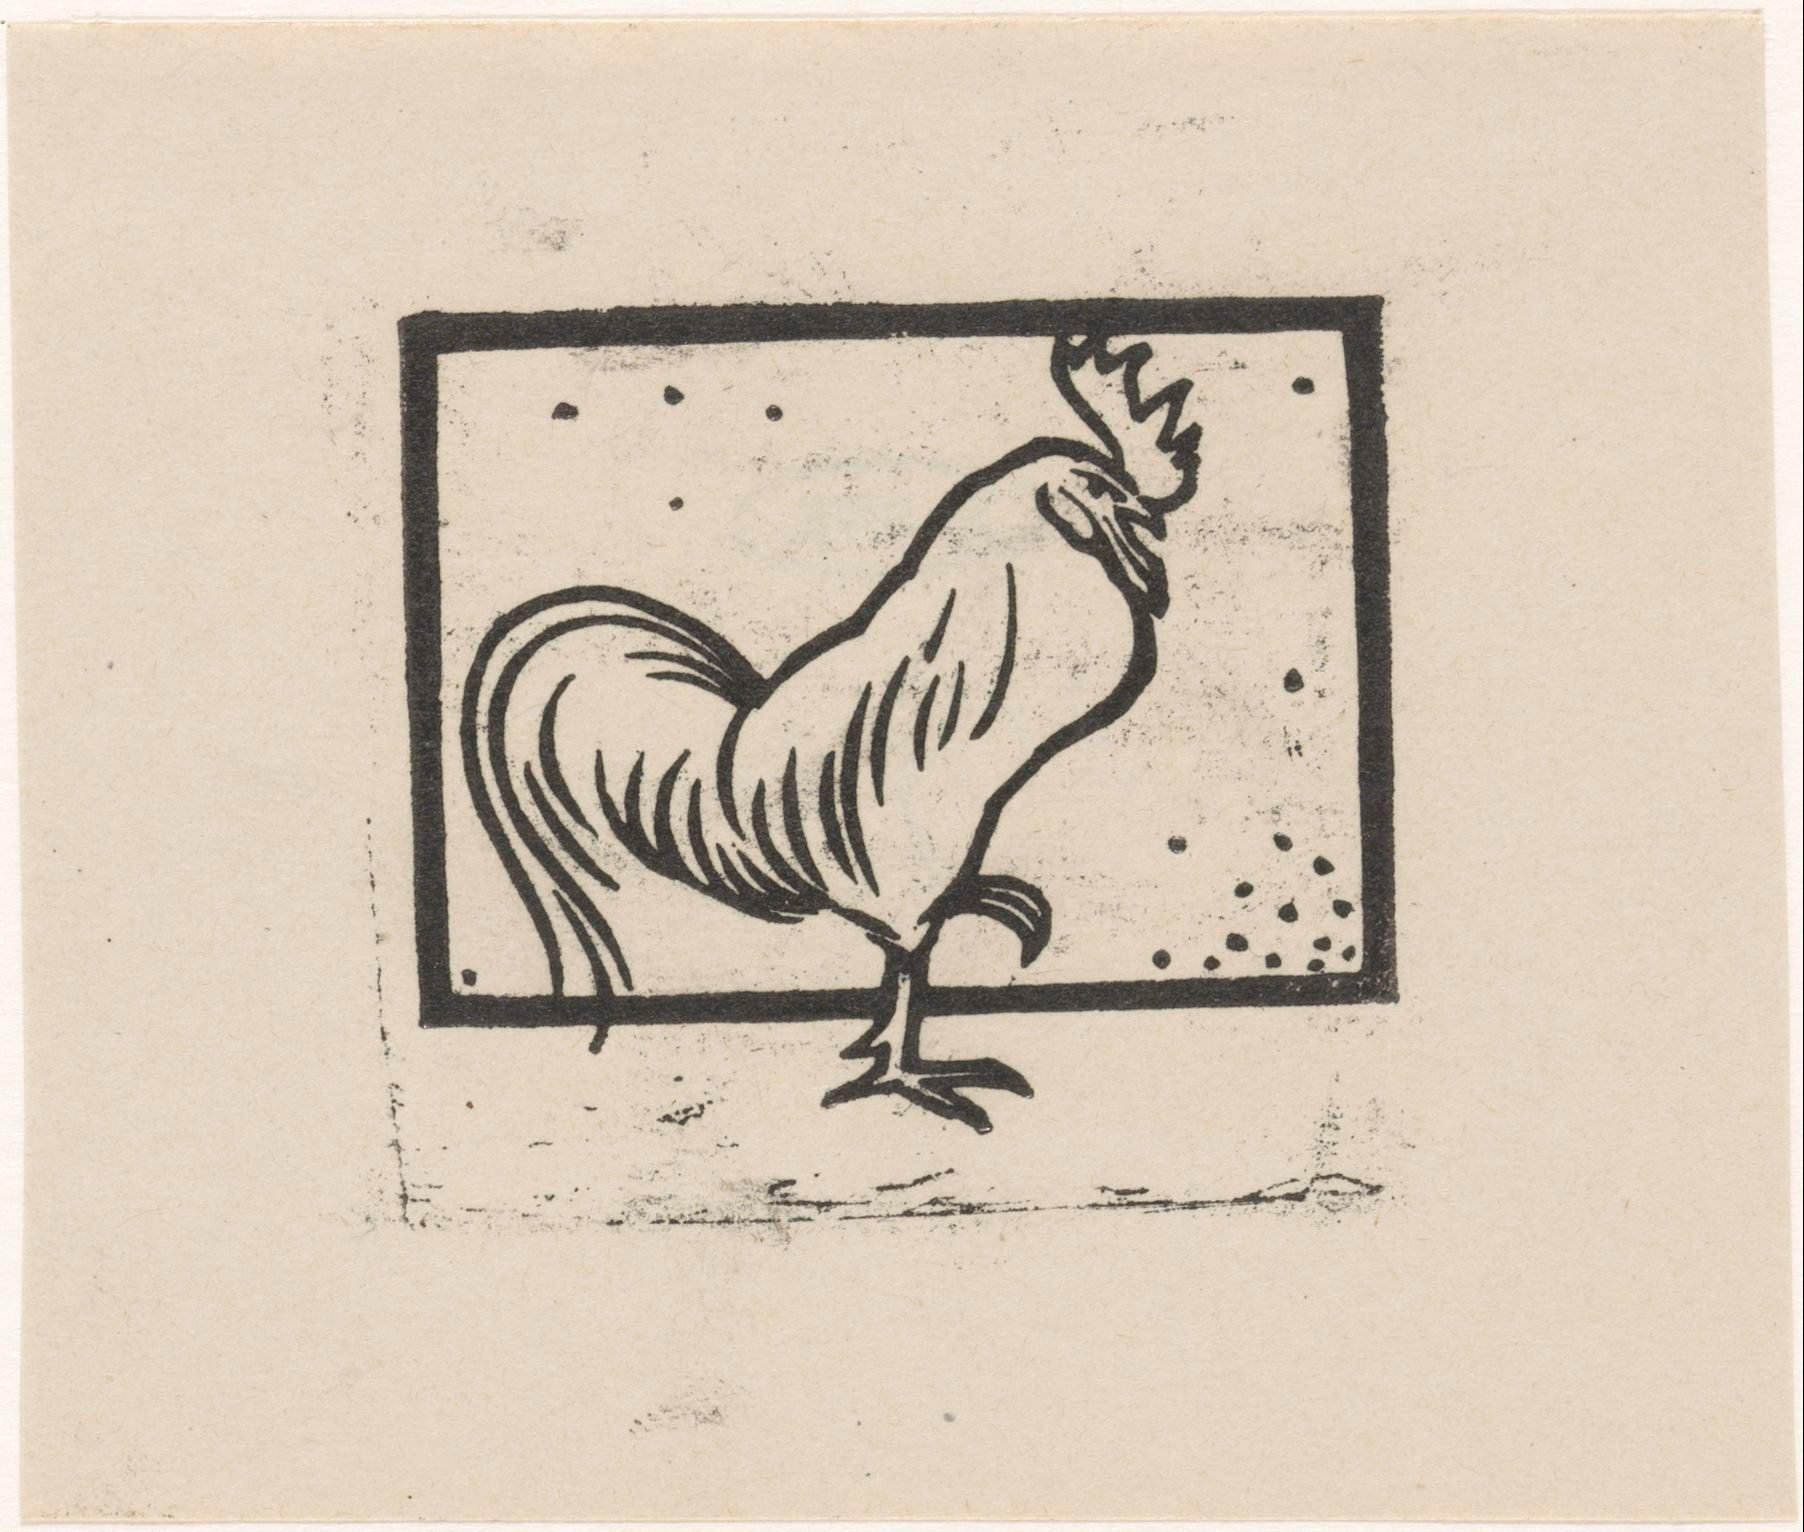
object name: print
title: Haan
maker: julie de graag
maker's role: draughtsman, print maker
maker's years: 1877-1924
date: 1887-1924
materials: paper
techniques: woodcut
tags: fowl (cock, hen, chicken, etc.)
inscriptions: collector's mark: Lugt 2228